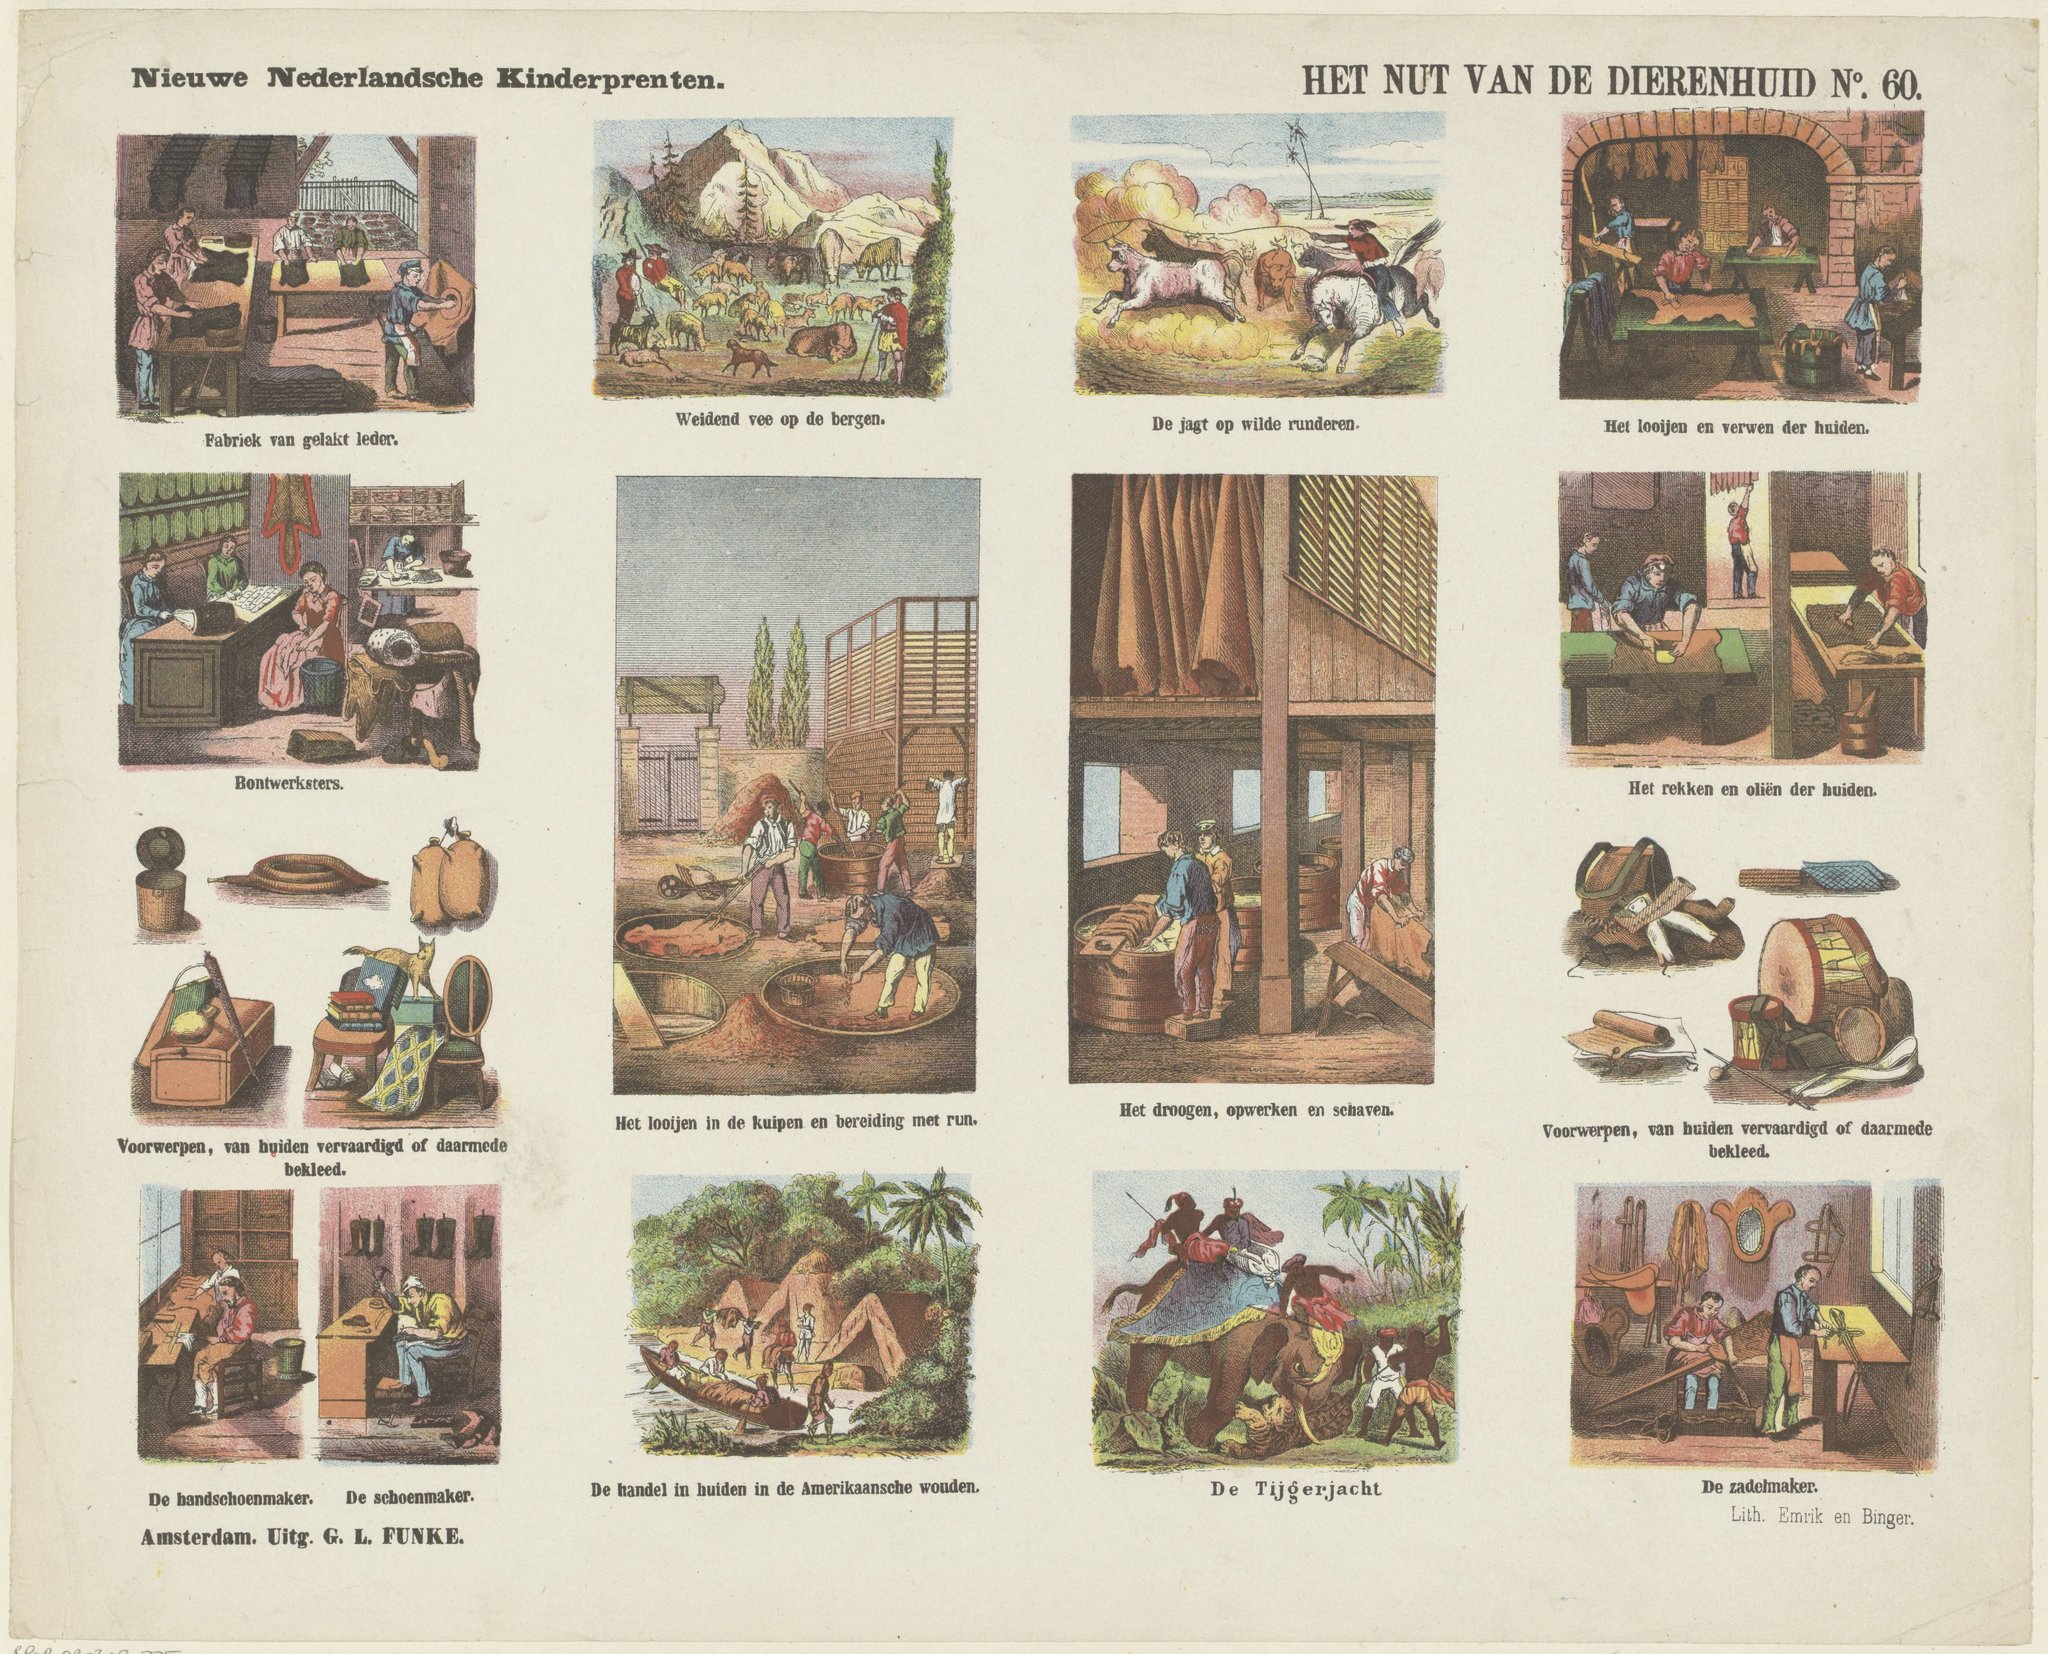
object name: print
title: Nieuwe Nederlandsche kinderprenten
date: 1865-1875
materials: paper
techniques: lithograph, letterpress printing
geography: haarlem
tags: animals (+ skin, fleece, hide, fur, leather), hunt ~ mammals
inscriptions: collector's mark: Lugt 2760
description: Blad met 15 voorstellingen van het jagen op dieren, het verwerken van dierenhuiden en producten van dierenhuid. Onder elke afbeelding een onderschrift. Genummerd rechtsboven: No. 60.